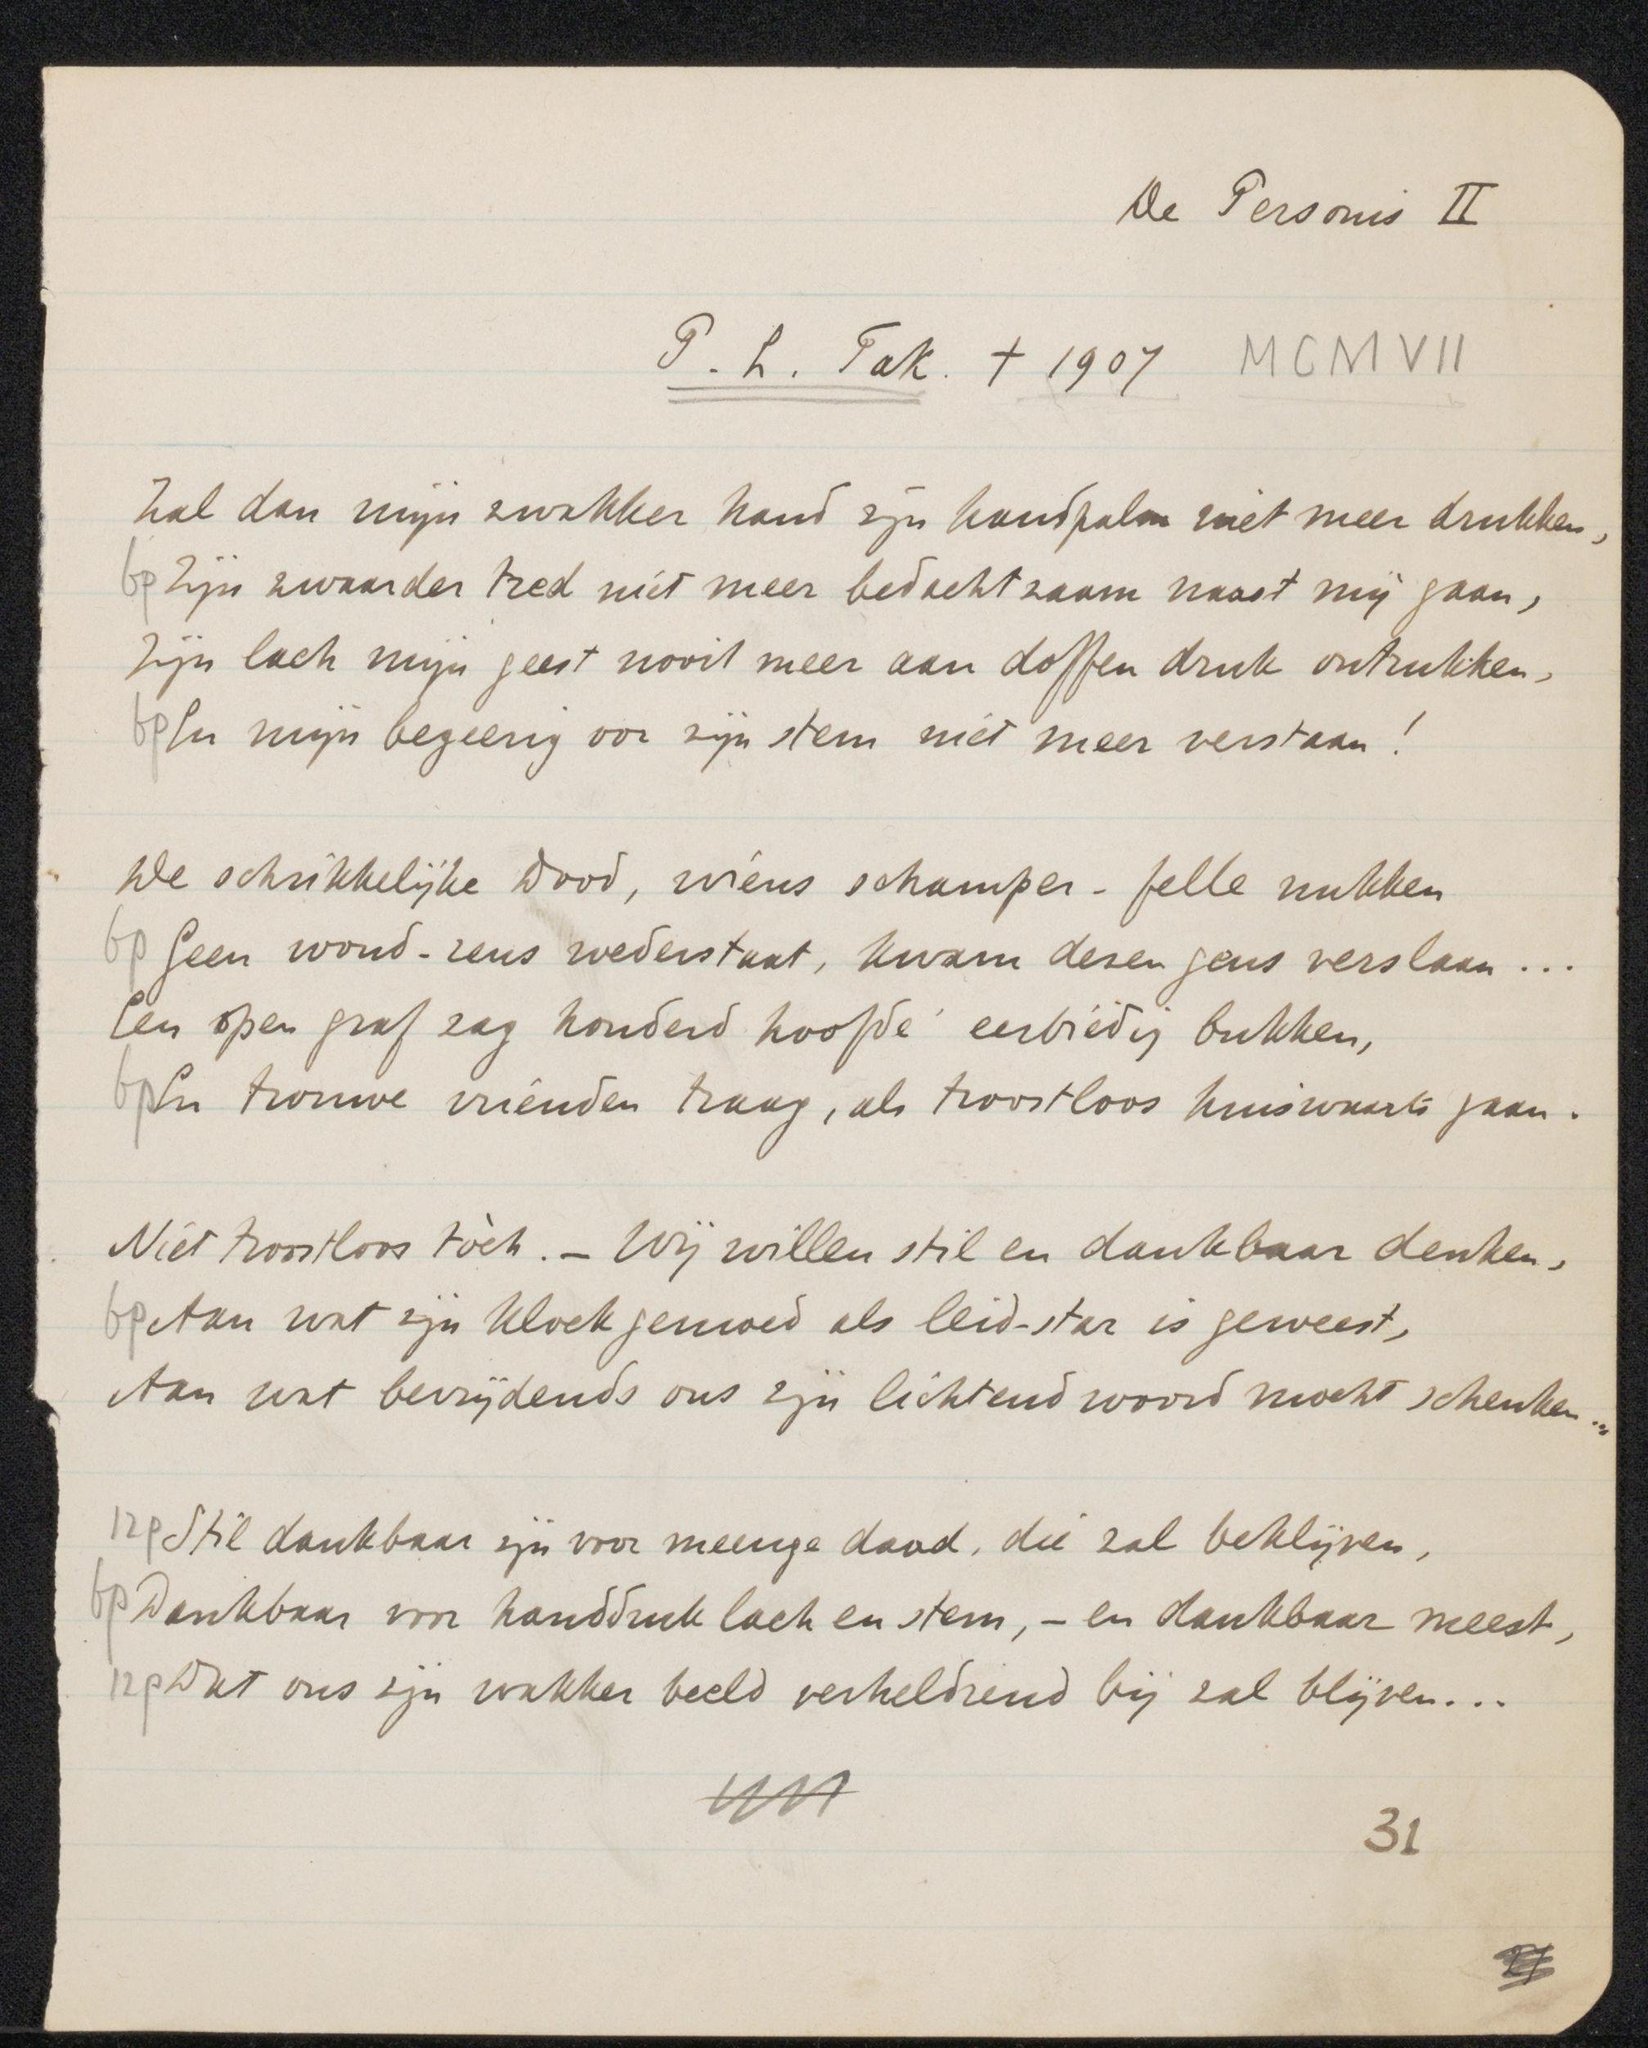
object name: poem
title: Gedicht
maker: jan veth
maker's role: designer, draughtsman, painter, print maker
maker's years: 1864-1925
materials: ink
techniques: pen, writing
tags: middelburg, politician, pieter lodewijk tak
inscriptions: collector's mark: ‘RPK’